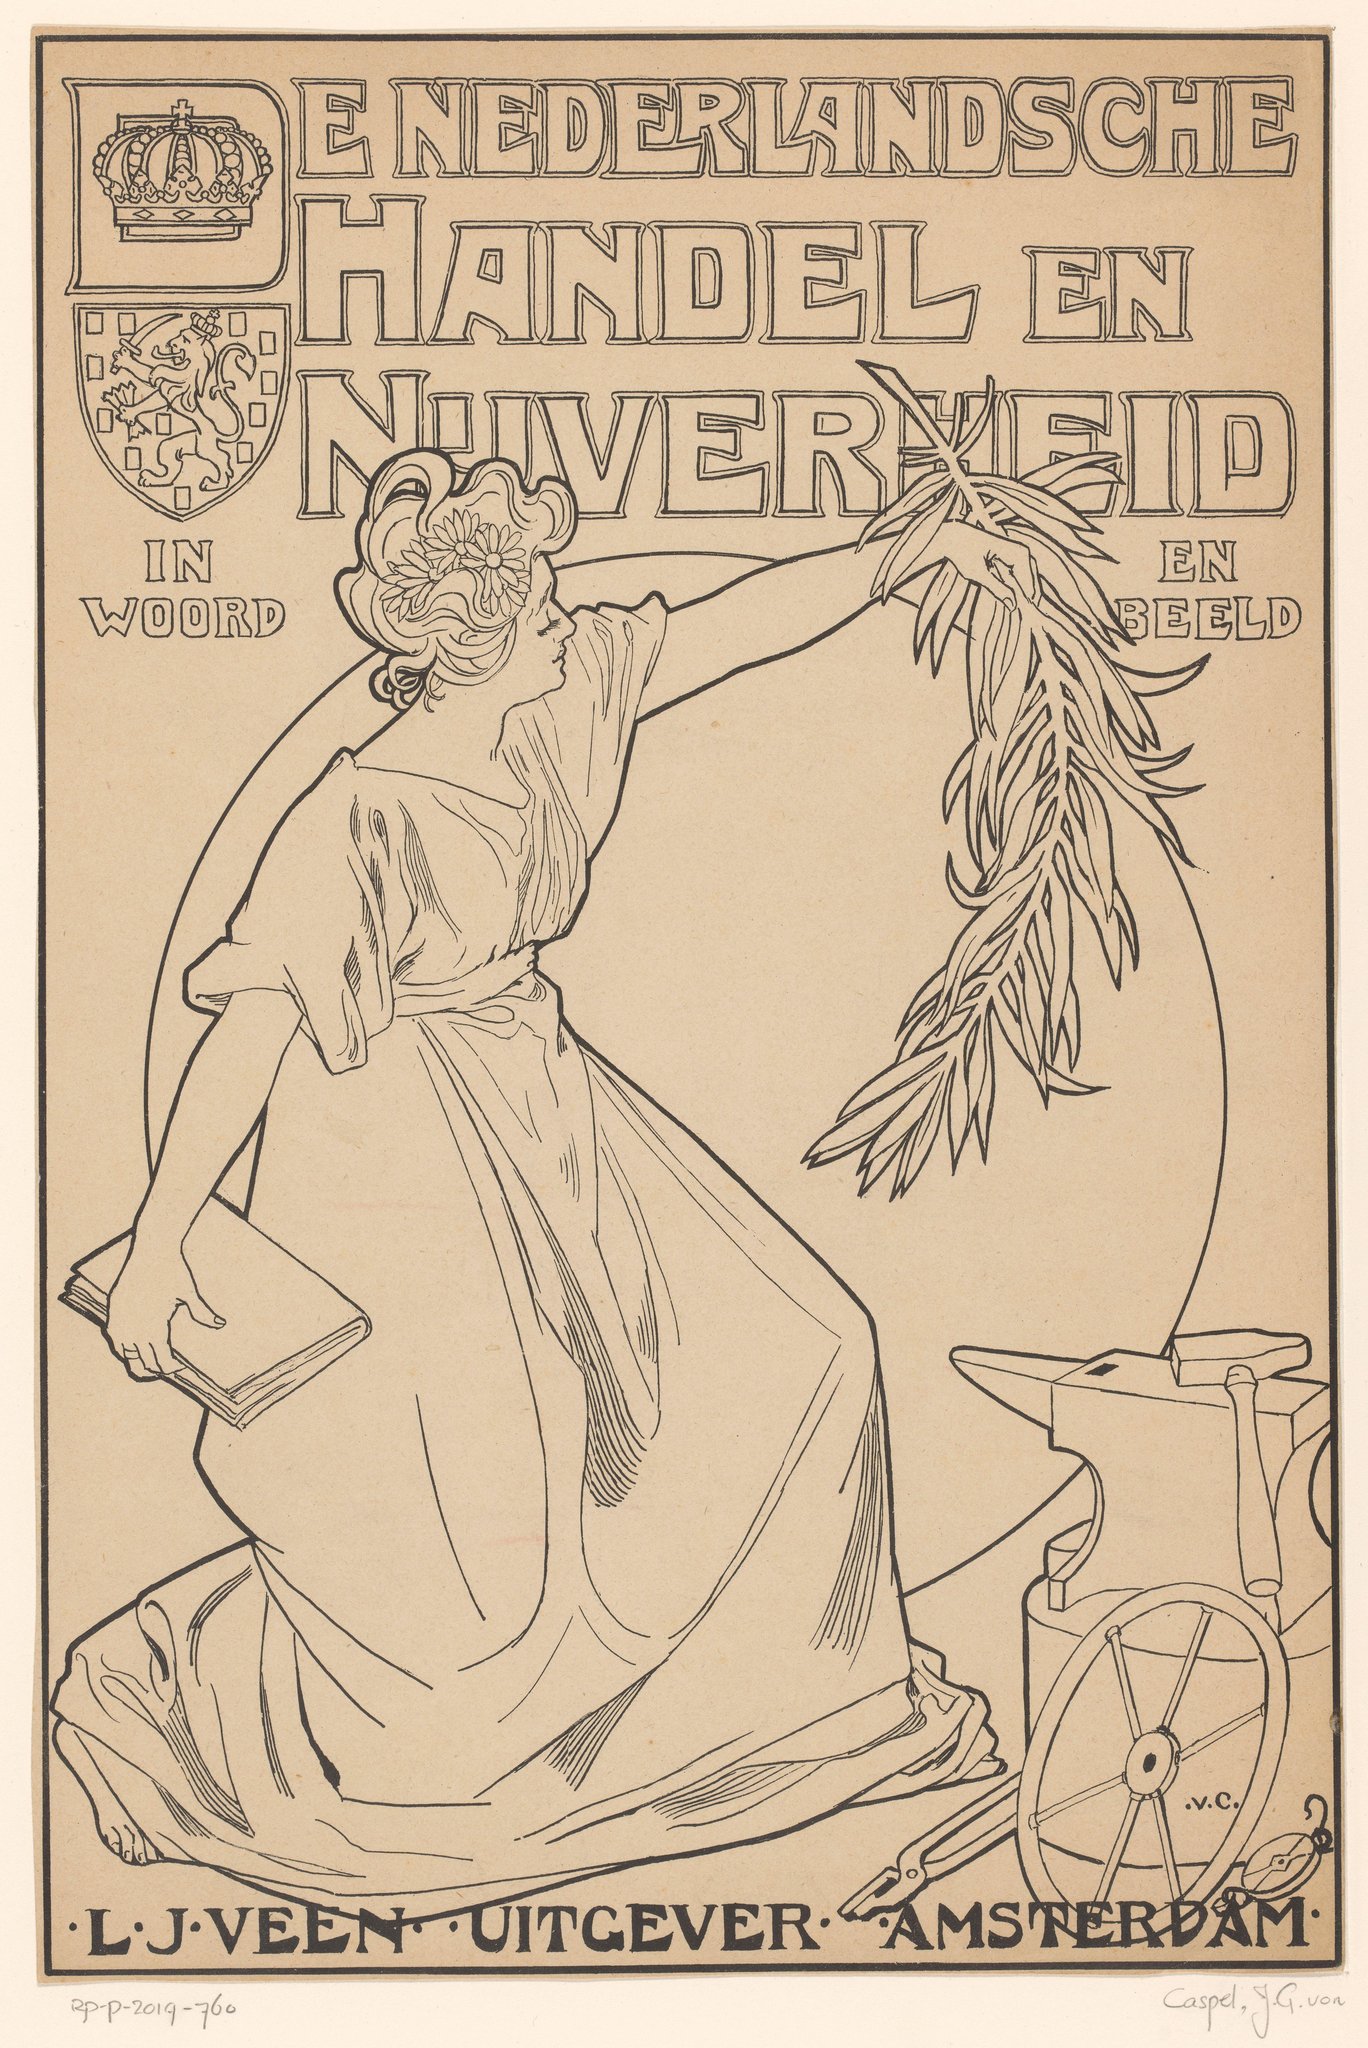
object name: design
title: Omslagontwerp voor: De Nederlandsche handel en nijverheid in woord en beeld, 1901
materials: paper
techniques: photochemical processes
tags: harbour, crafts and industries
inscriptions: collector's mark: Lugt 2228a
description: Een vrouw in een lang gewaad met een bloem in het haar zit voor een havengezicht gevat in een cirkel. In haar rechterhand houdt de vrouw een boek vast, in haar linkerhand een palmtak. Naast haar liggen verschillende gereedschappen.